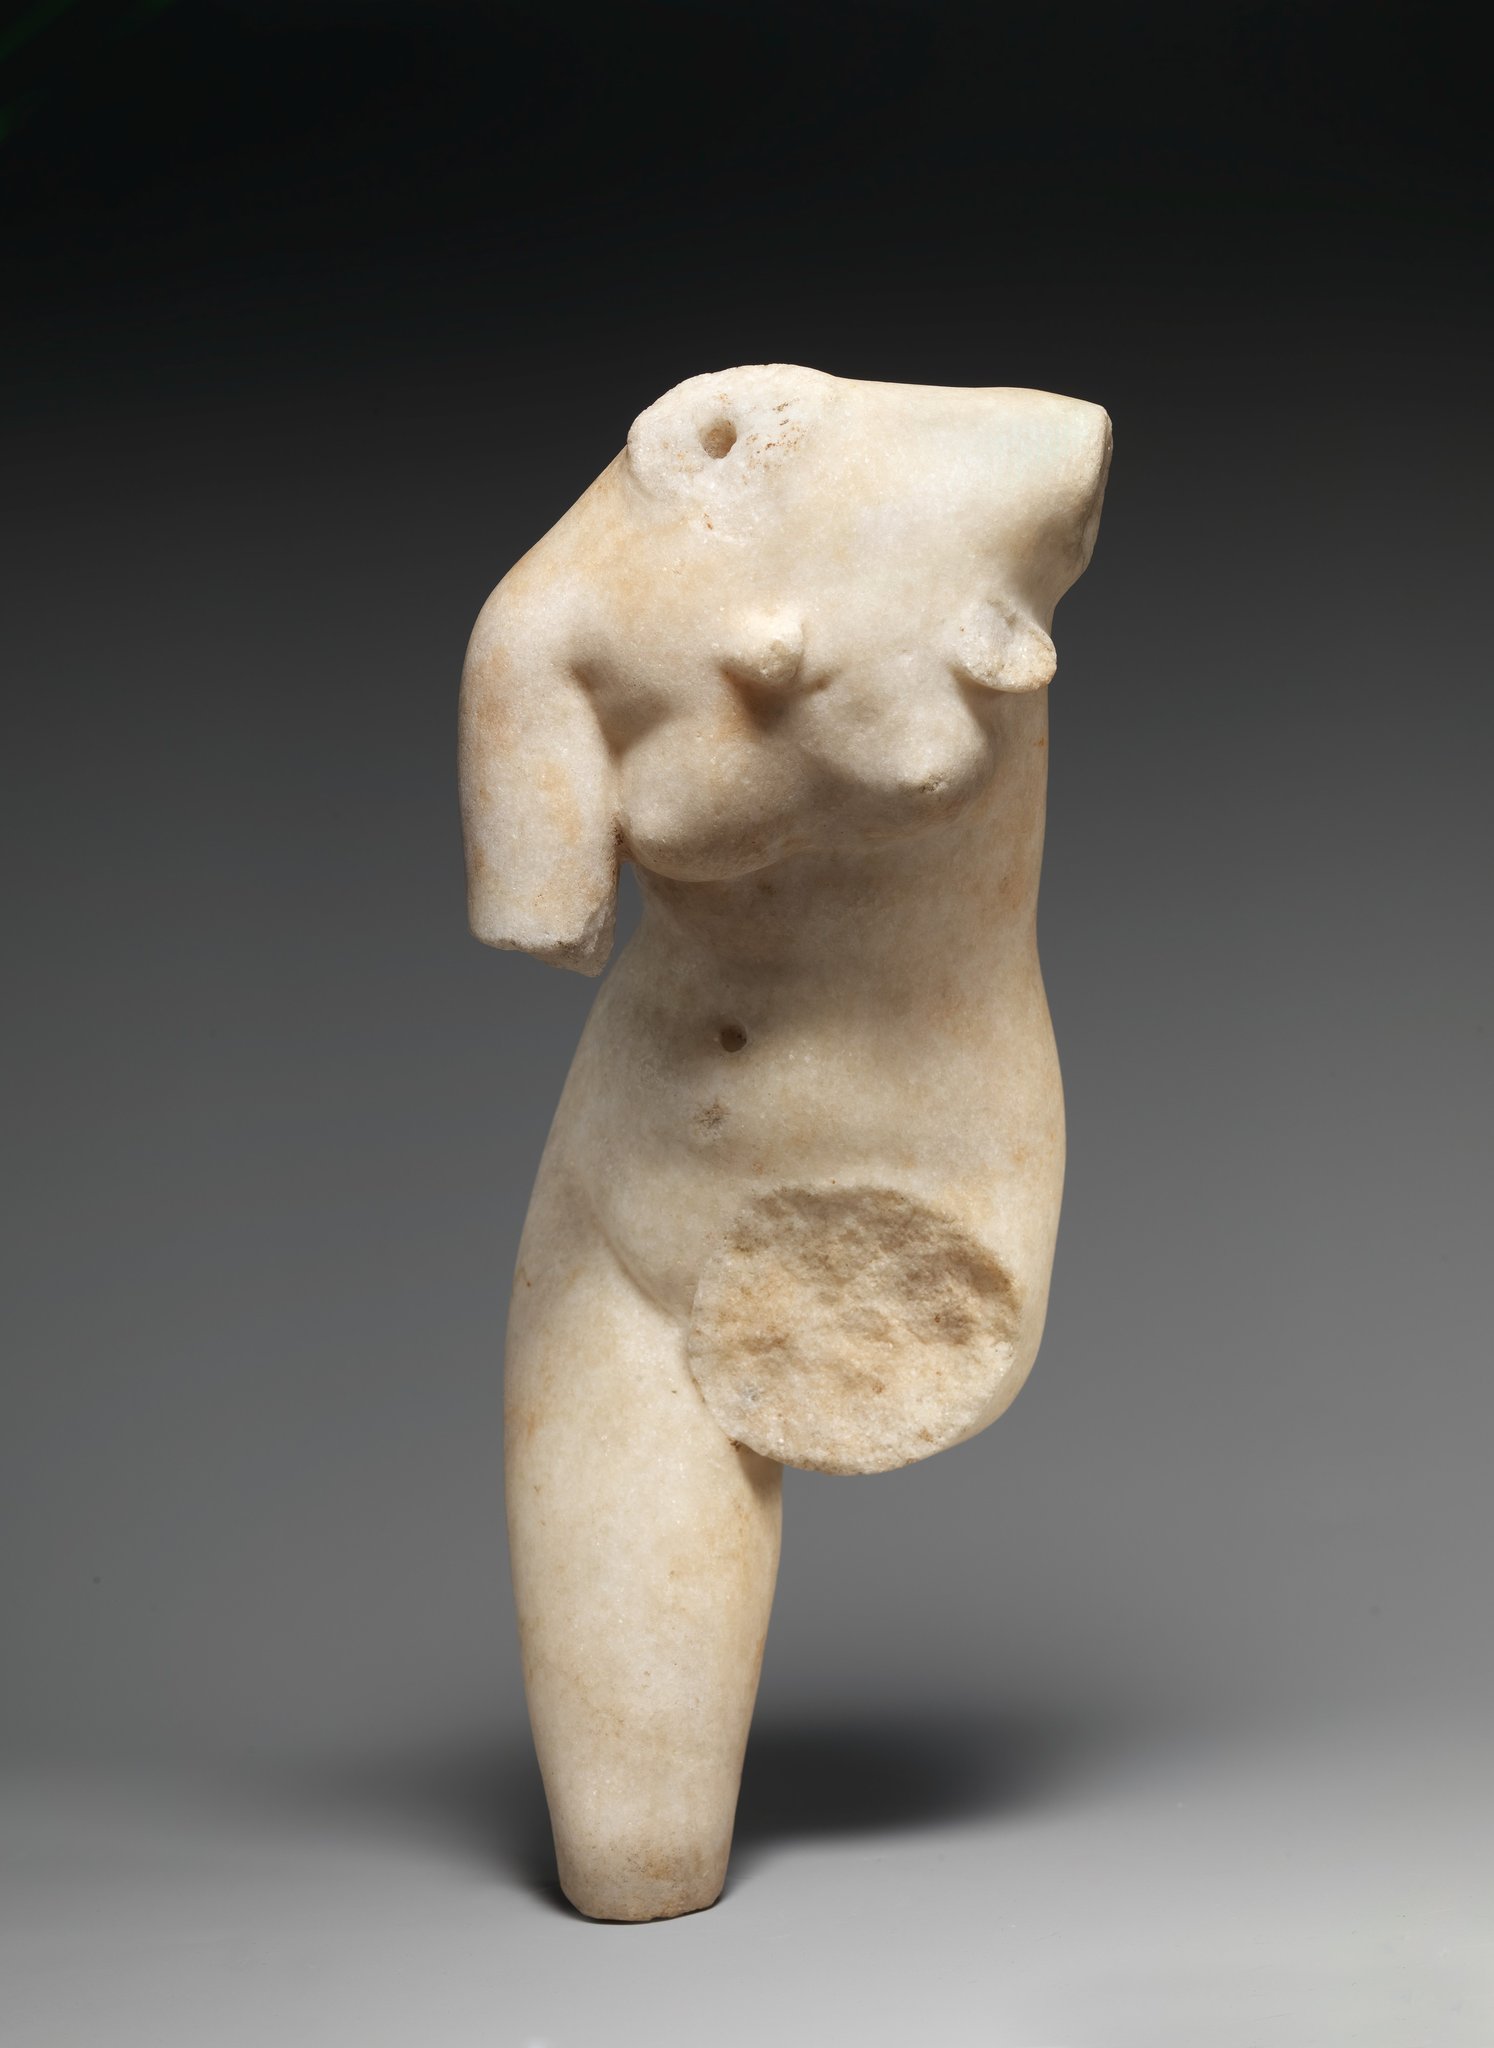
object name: statuette of aphrodite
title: Marble statue of Aphrodite loosening her sandal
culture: roman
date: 1-100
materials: marble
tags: aphrodite